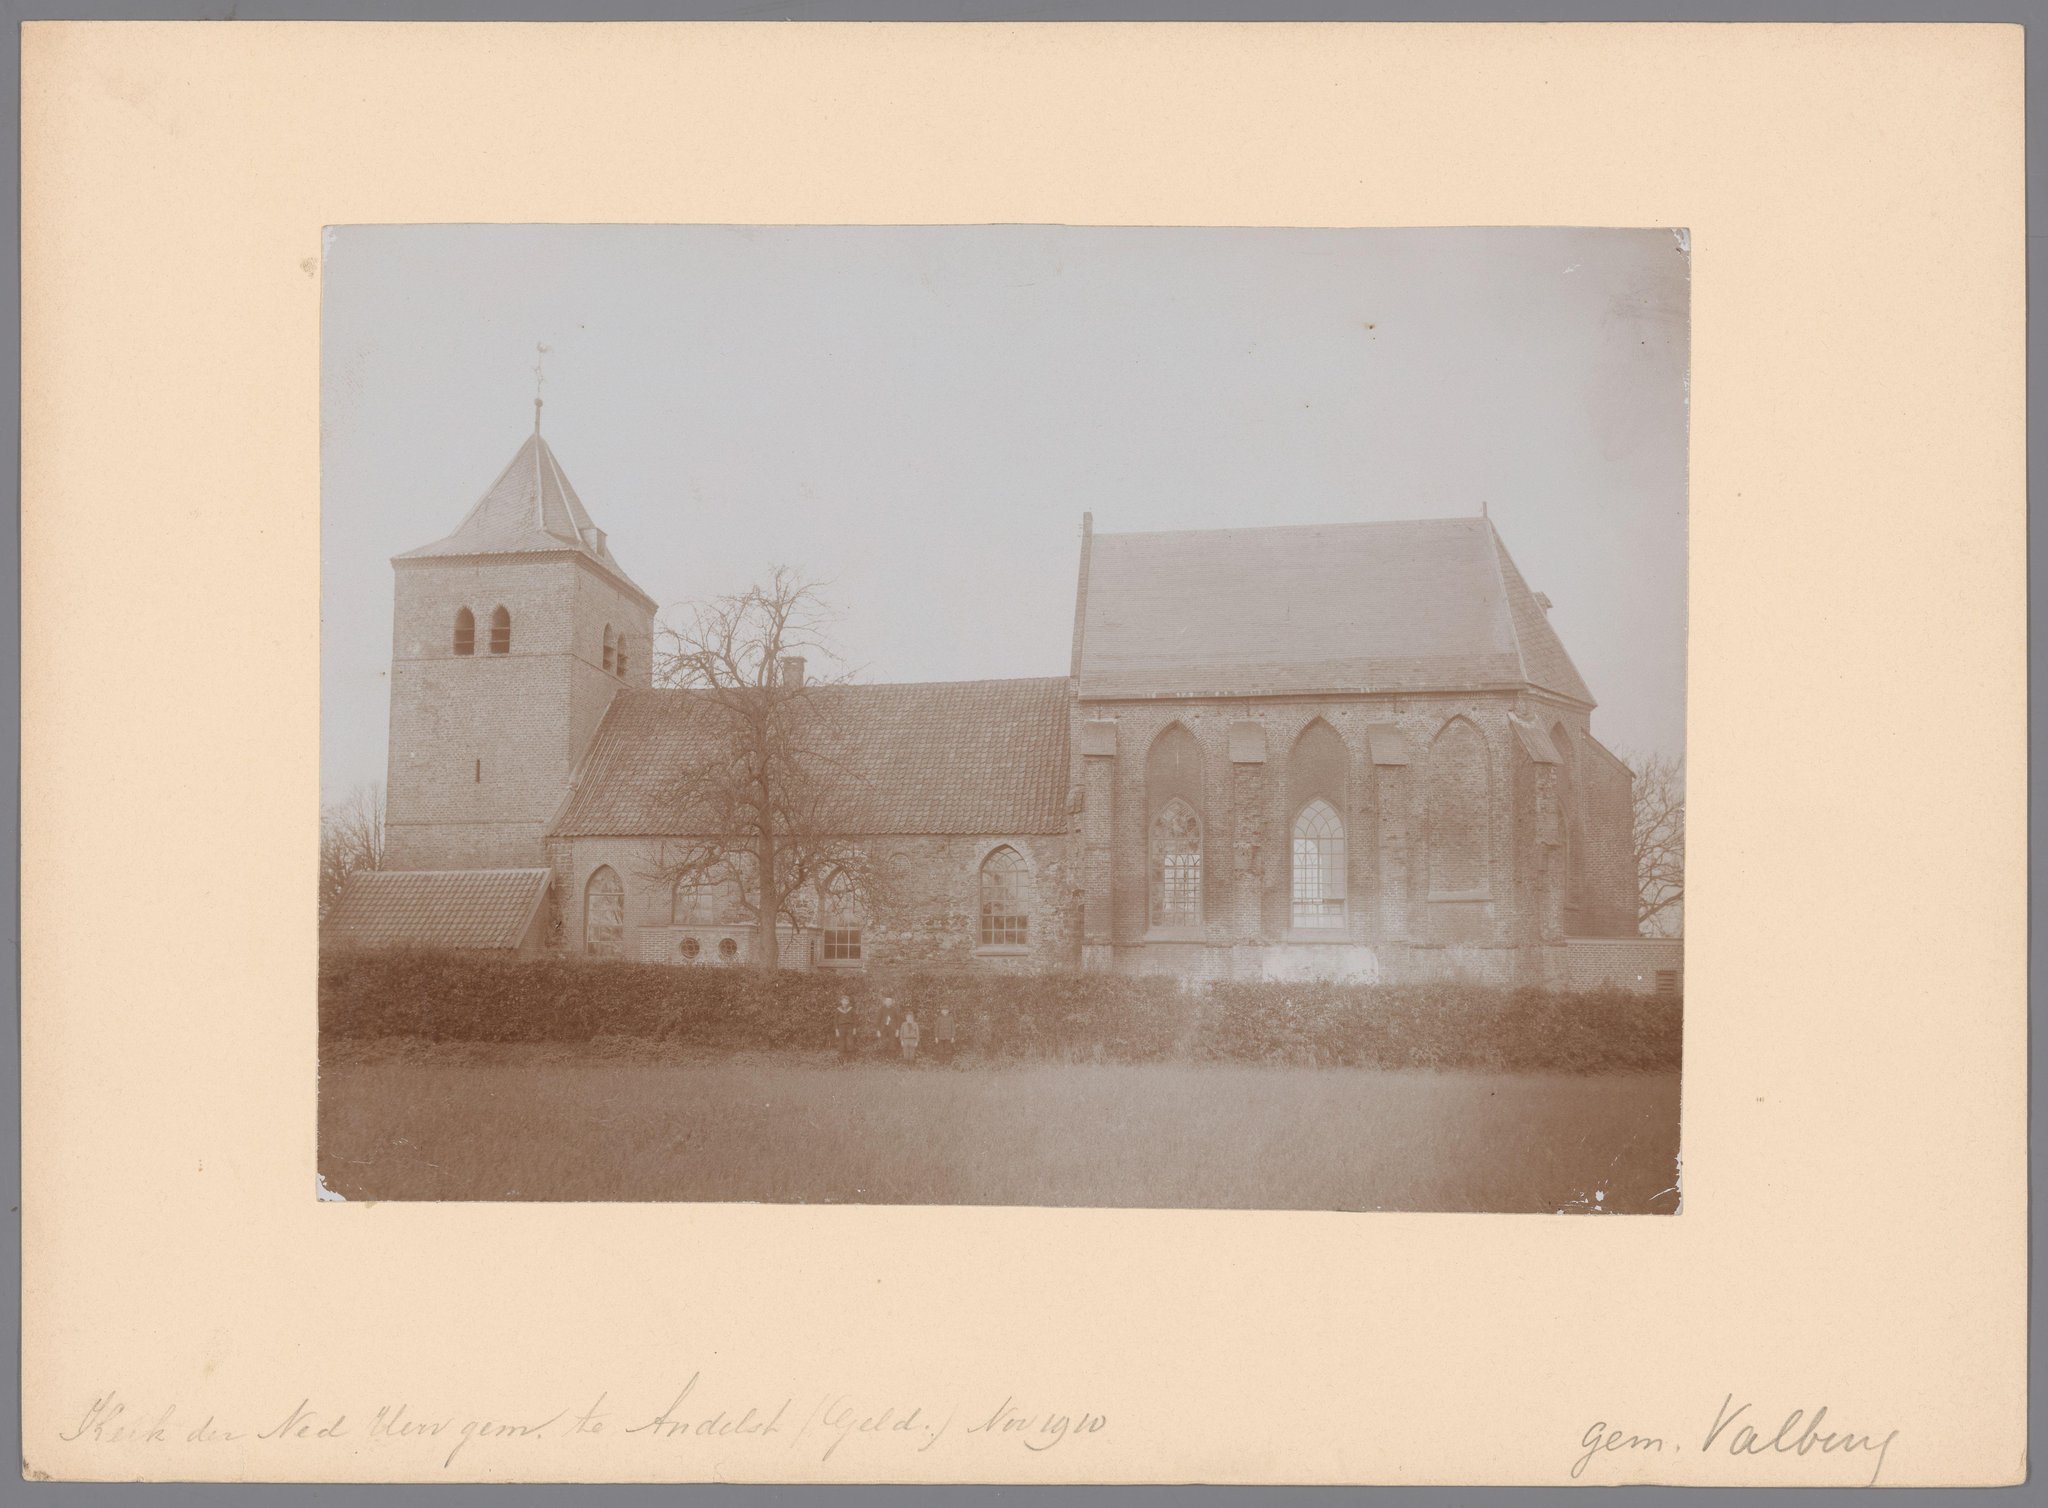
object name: photograph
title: Gezicht op de Hervormde Kerk te Andelst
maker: anoniem (monumentenzorg)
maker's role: fotograaf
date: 1910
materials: cardboard, photographic support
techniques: collodion silver print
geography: andelst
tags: church (exterior)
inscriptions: annotation: ‘Kerk der Ned. Herv. gem. te Andelst/ Geld./ Nov 1910/ Gem. Valburg’